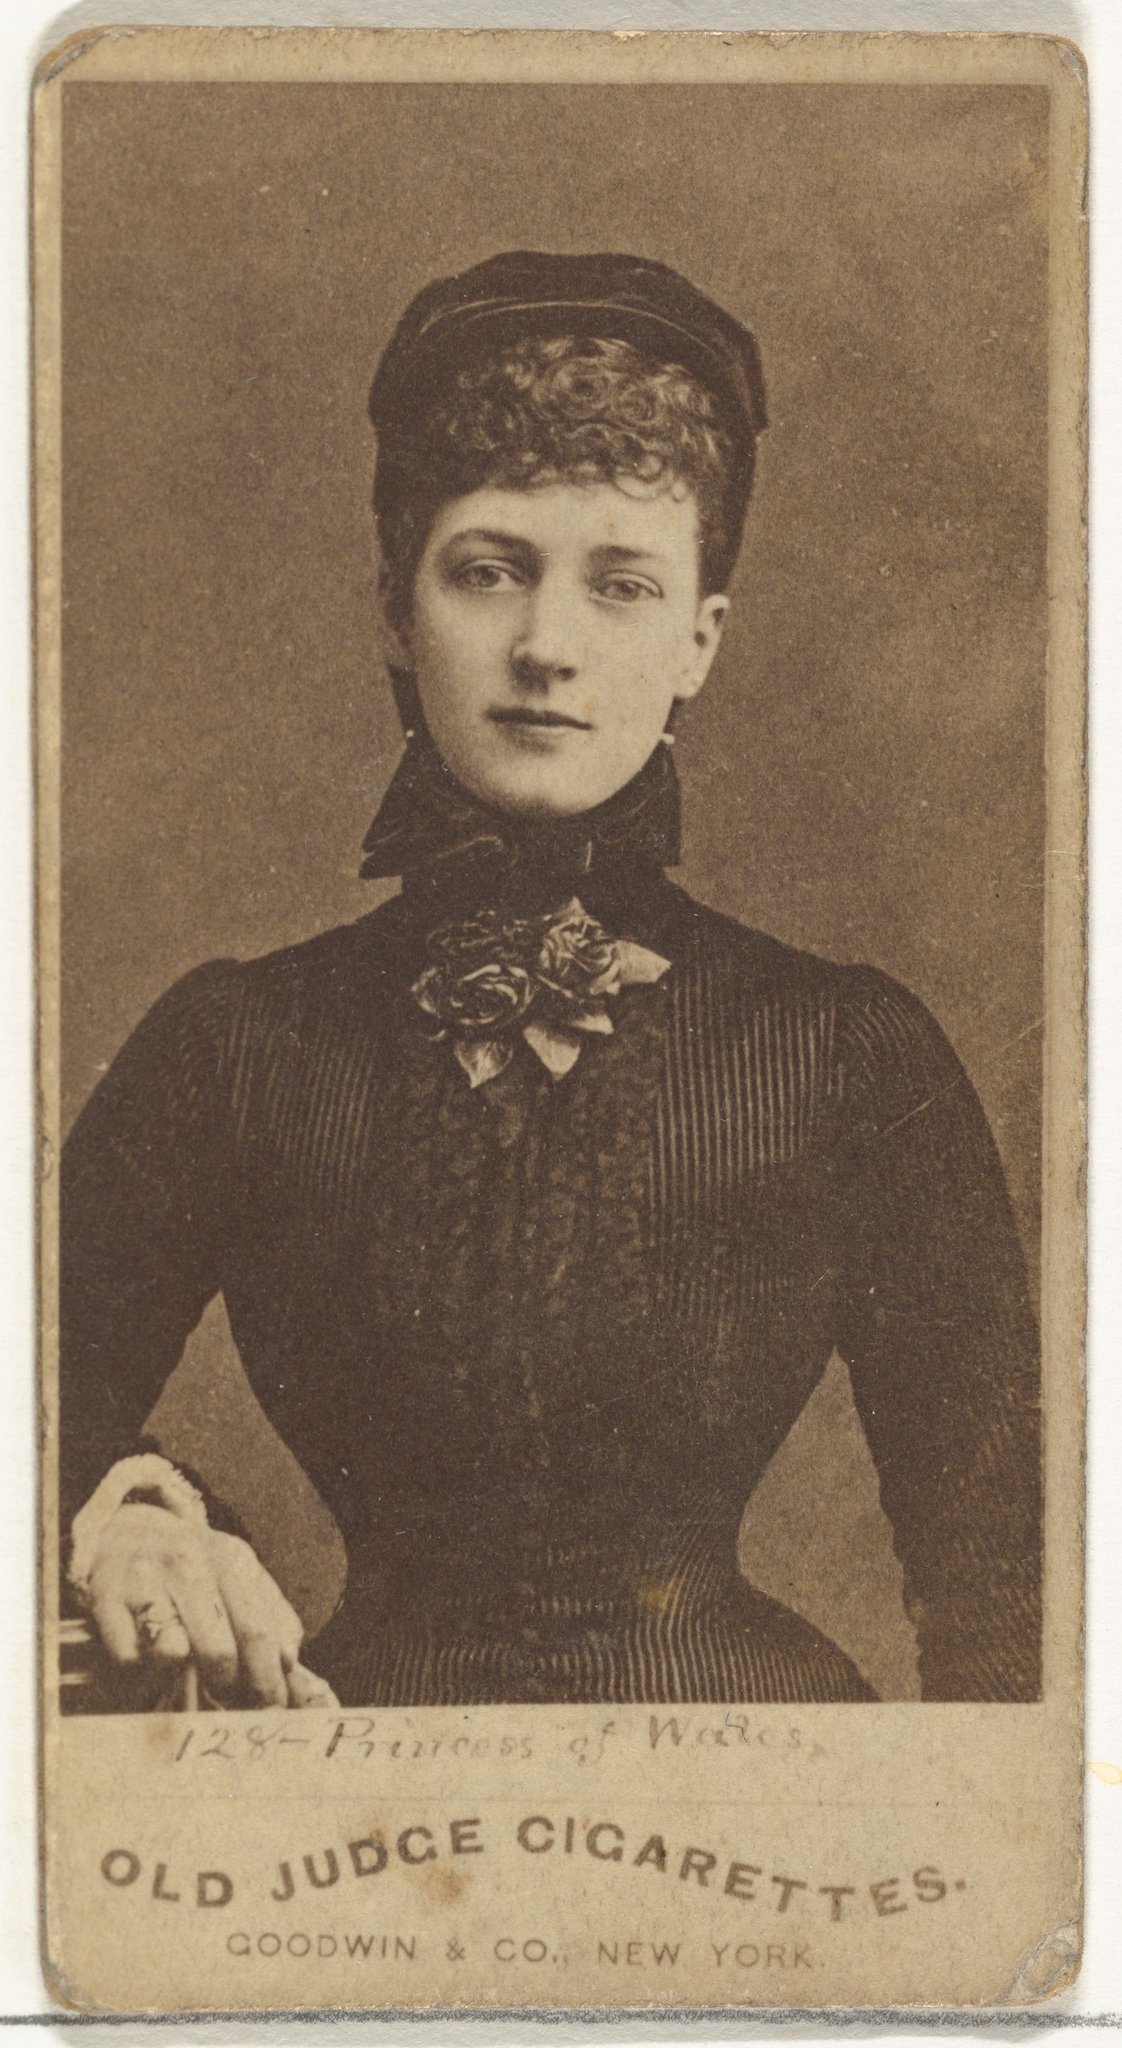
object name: photograph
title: Princess of Wales, from the Actors and Actresses series (N171) for Old Judge Cigarettes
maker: goodwin & company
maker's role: publisher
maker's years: 1850-1950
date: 1886-1890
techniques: albumen silver print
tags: portraits,women,actresses